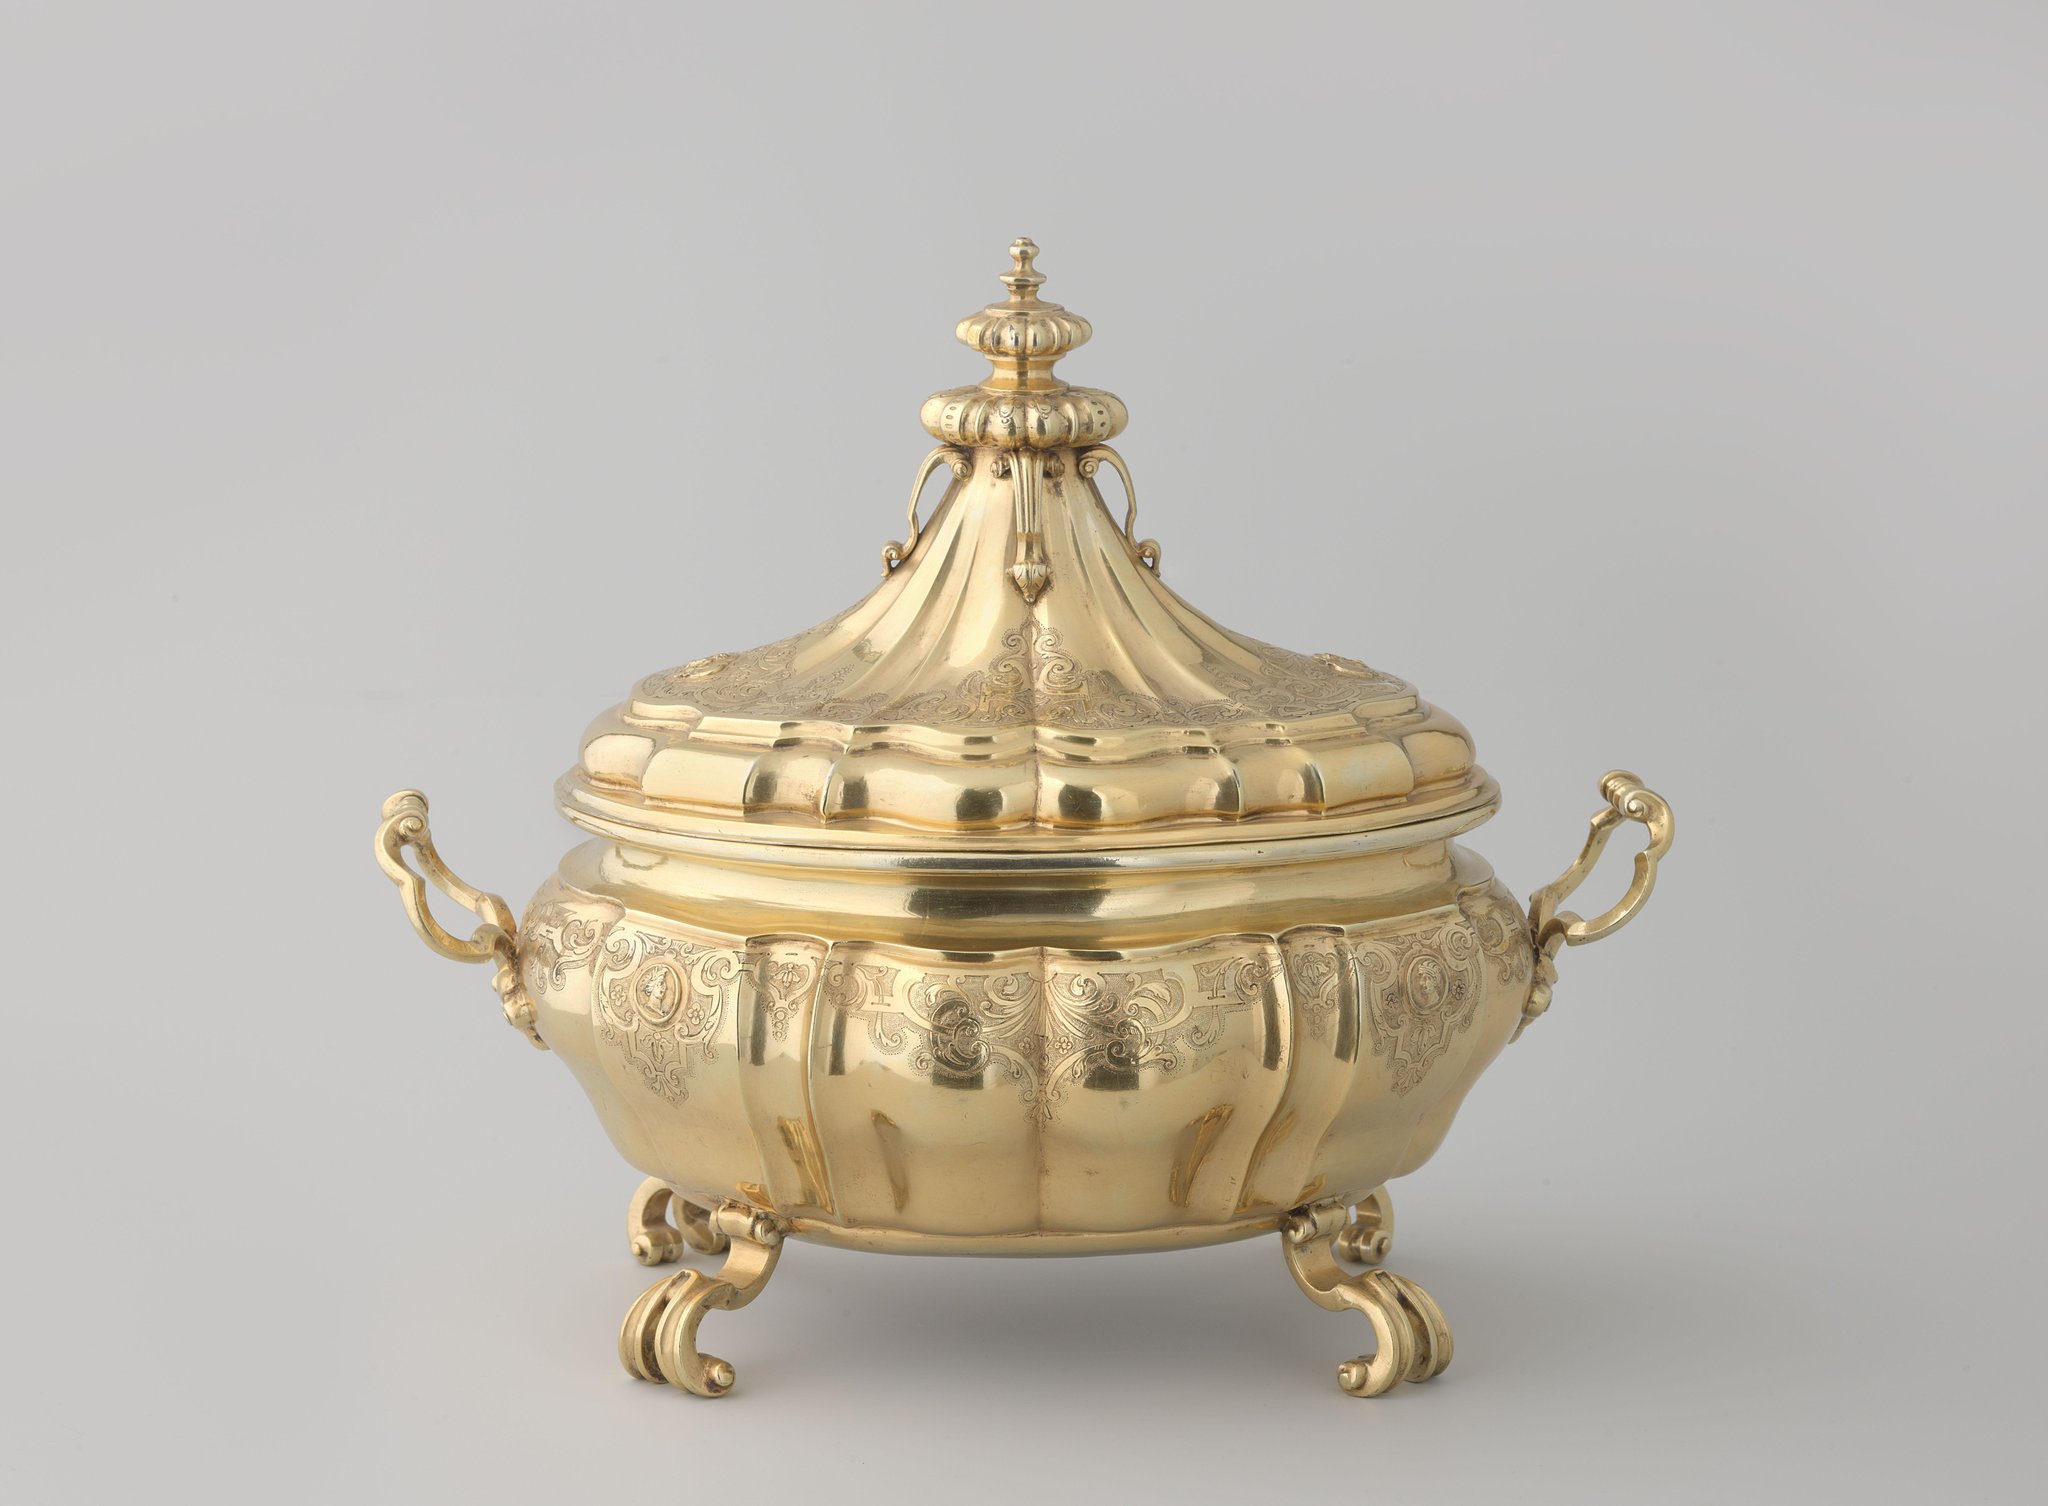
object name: tureen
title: Terrine met deksel, van verguld zilver, rustend op vier poten. Verticaal geleed vat in holle en bolle vakken. Deksel overeenkomstig geleed, met geprofileerde knop. Versiering van bandwerk. Met bijbehorende onderschotel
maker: christian drentwett (i)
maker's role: silversmith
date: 1732-1733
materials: silver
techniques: gilding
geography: augsburg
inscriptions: mark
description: Terrine. Verguld zilver. Augsburg, ca. 1732 - 1733, door Christian Drentwett I.